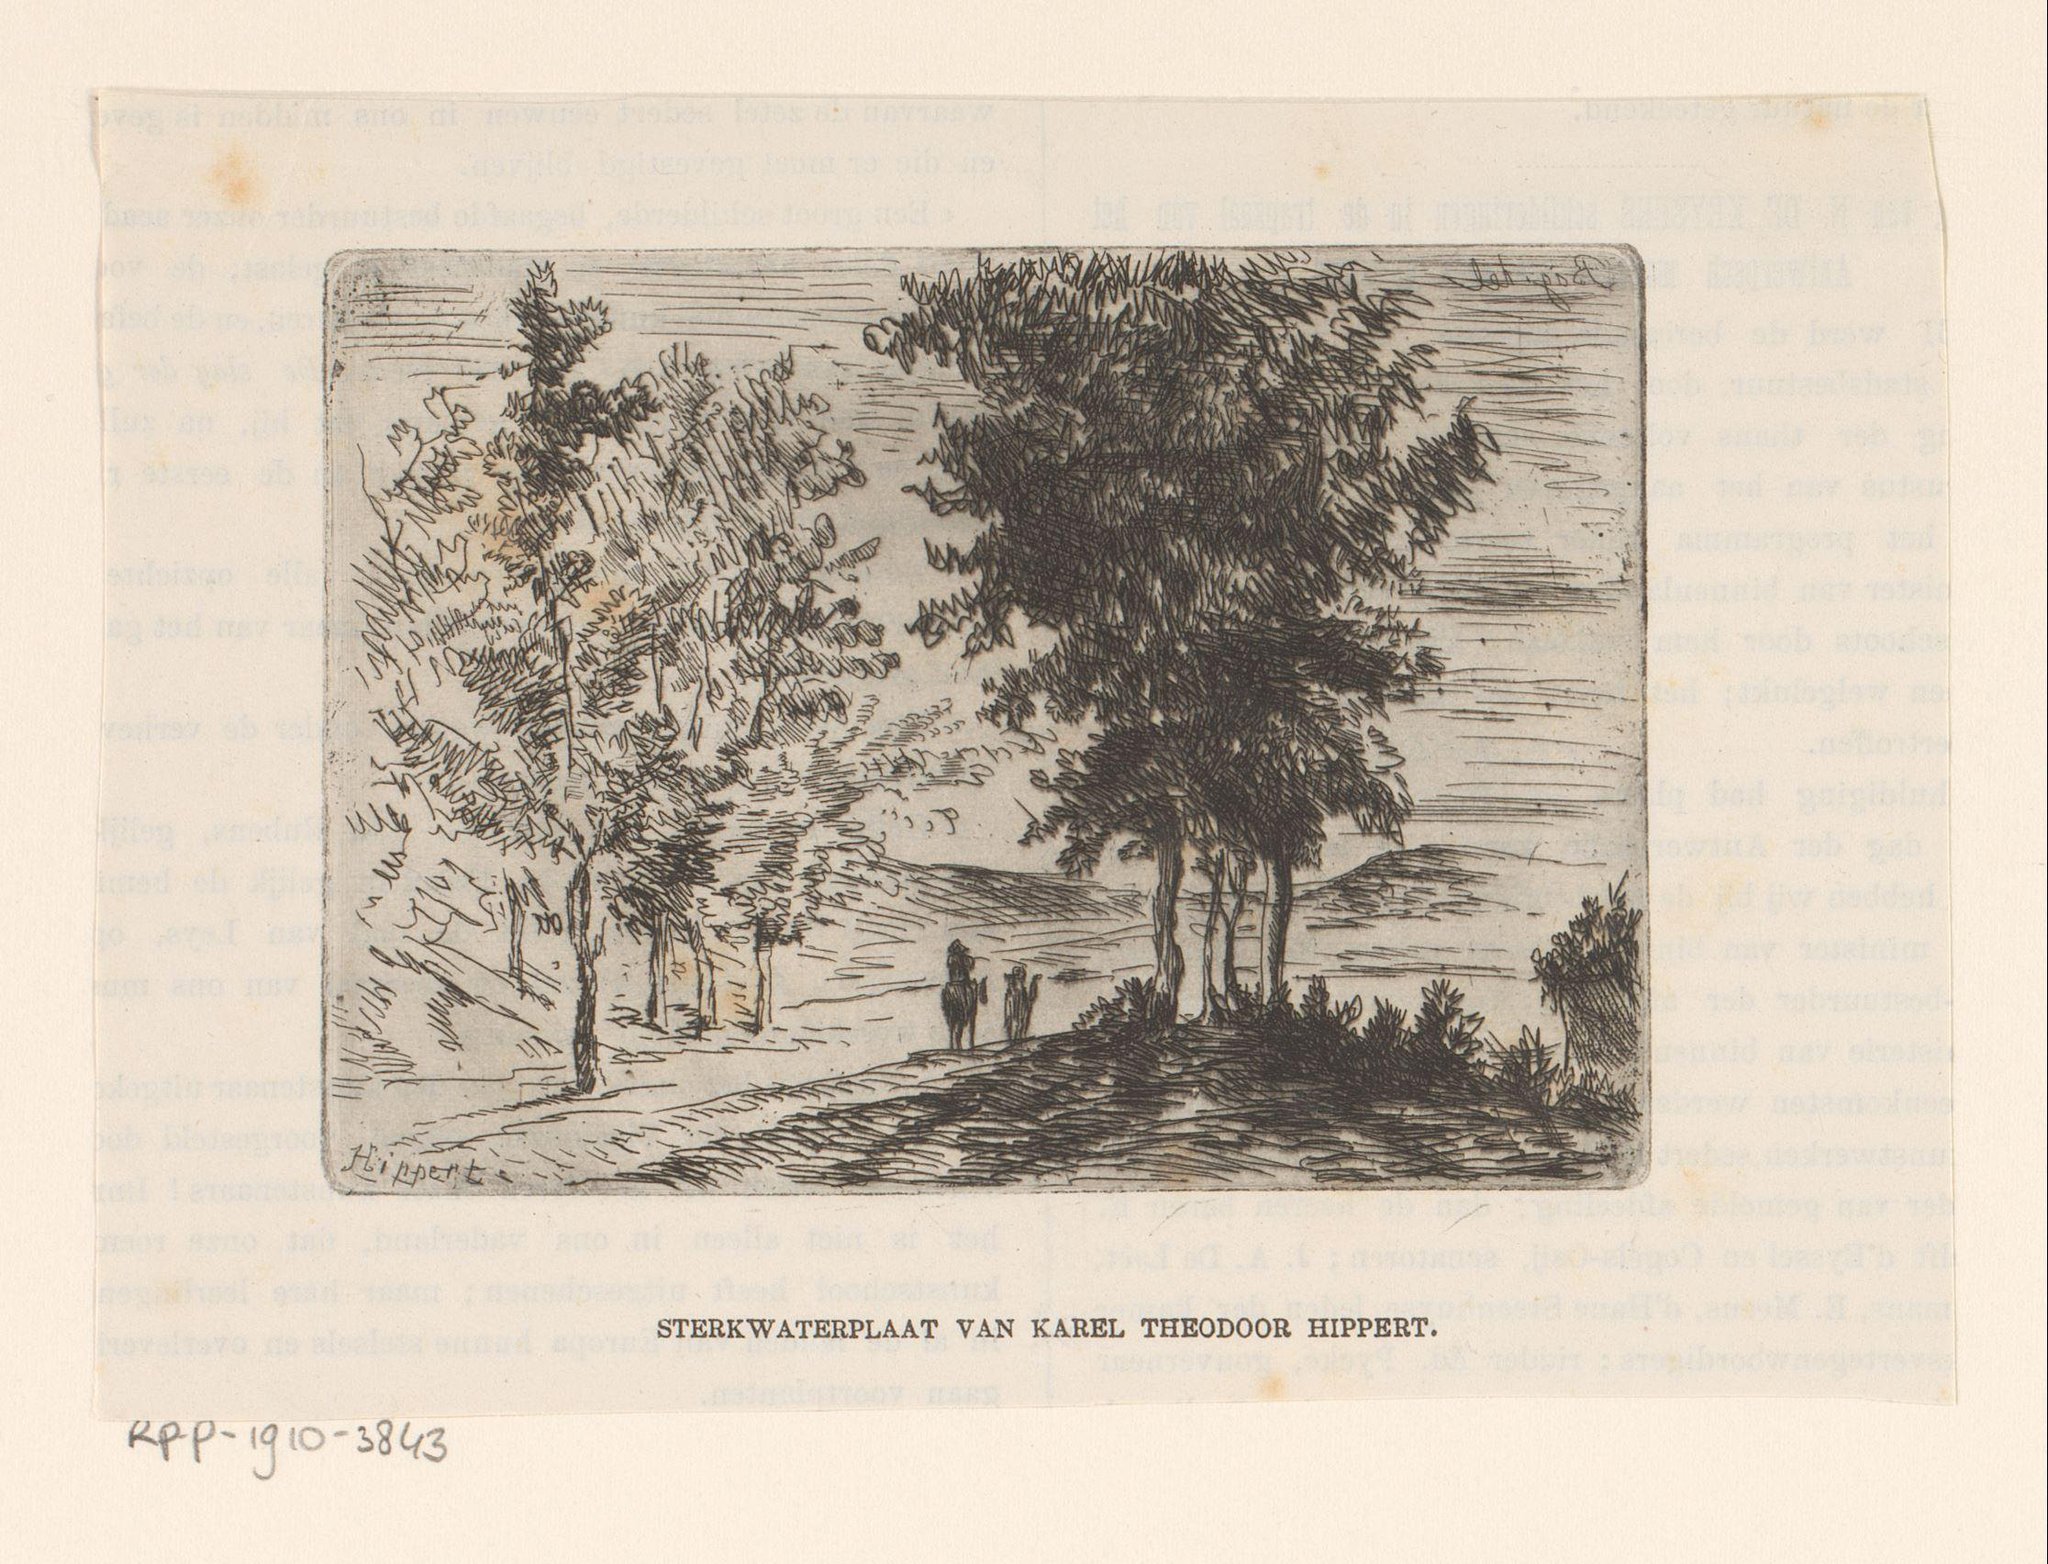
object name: print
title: Landschap met twee ruiters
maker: karel theodoor hippert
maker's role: print maker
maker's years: 1839-1919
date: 1849-1910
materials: paper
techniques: etching, intaglio, letterpress printing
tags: riding a horse, ass, or mule; rider, horseman, landscapes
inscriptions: collector's mark: Lugt 2228